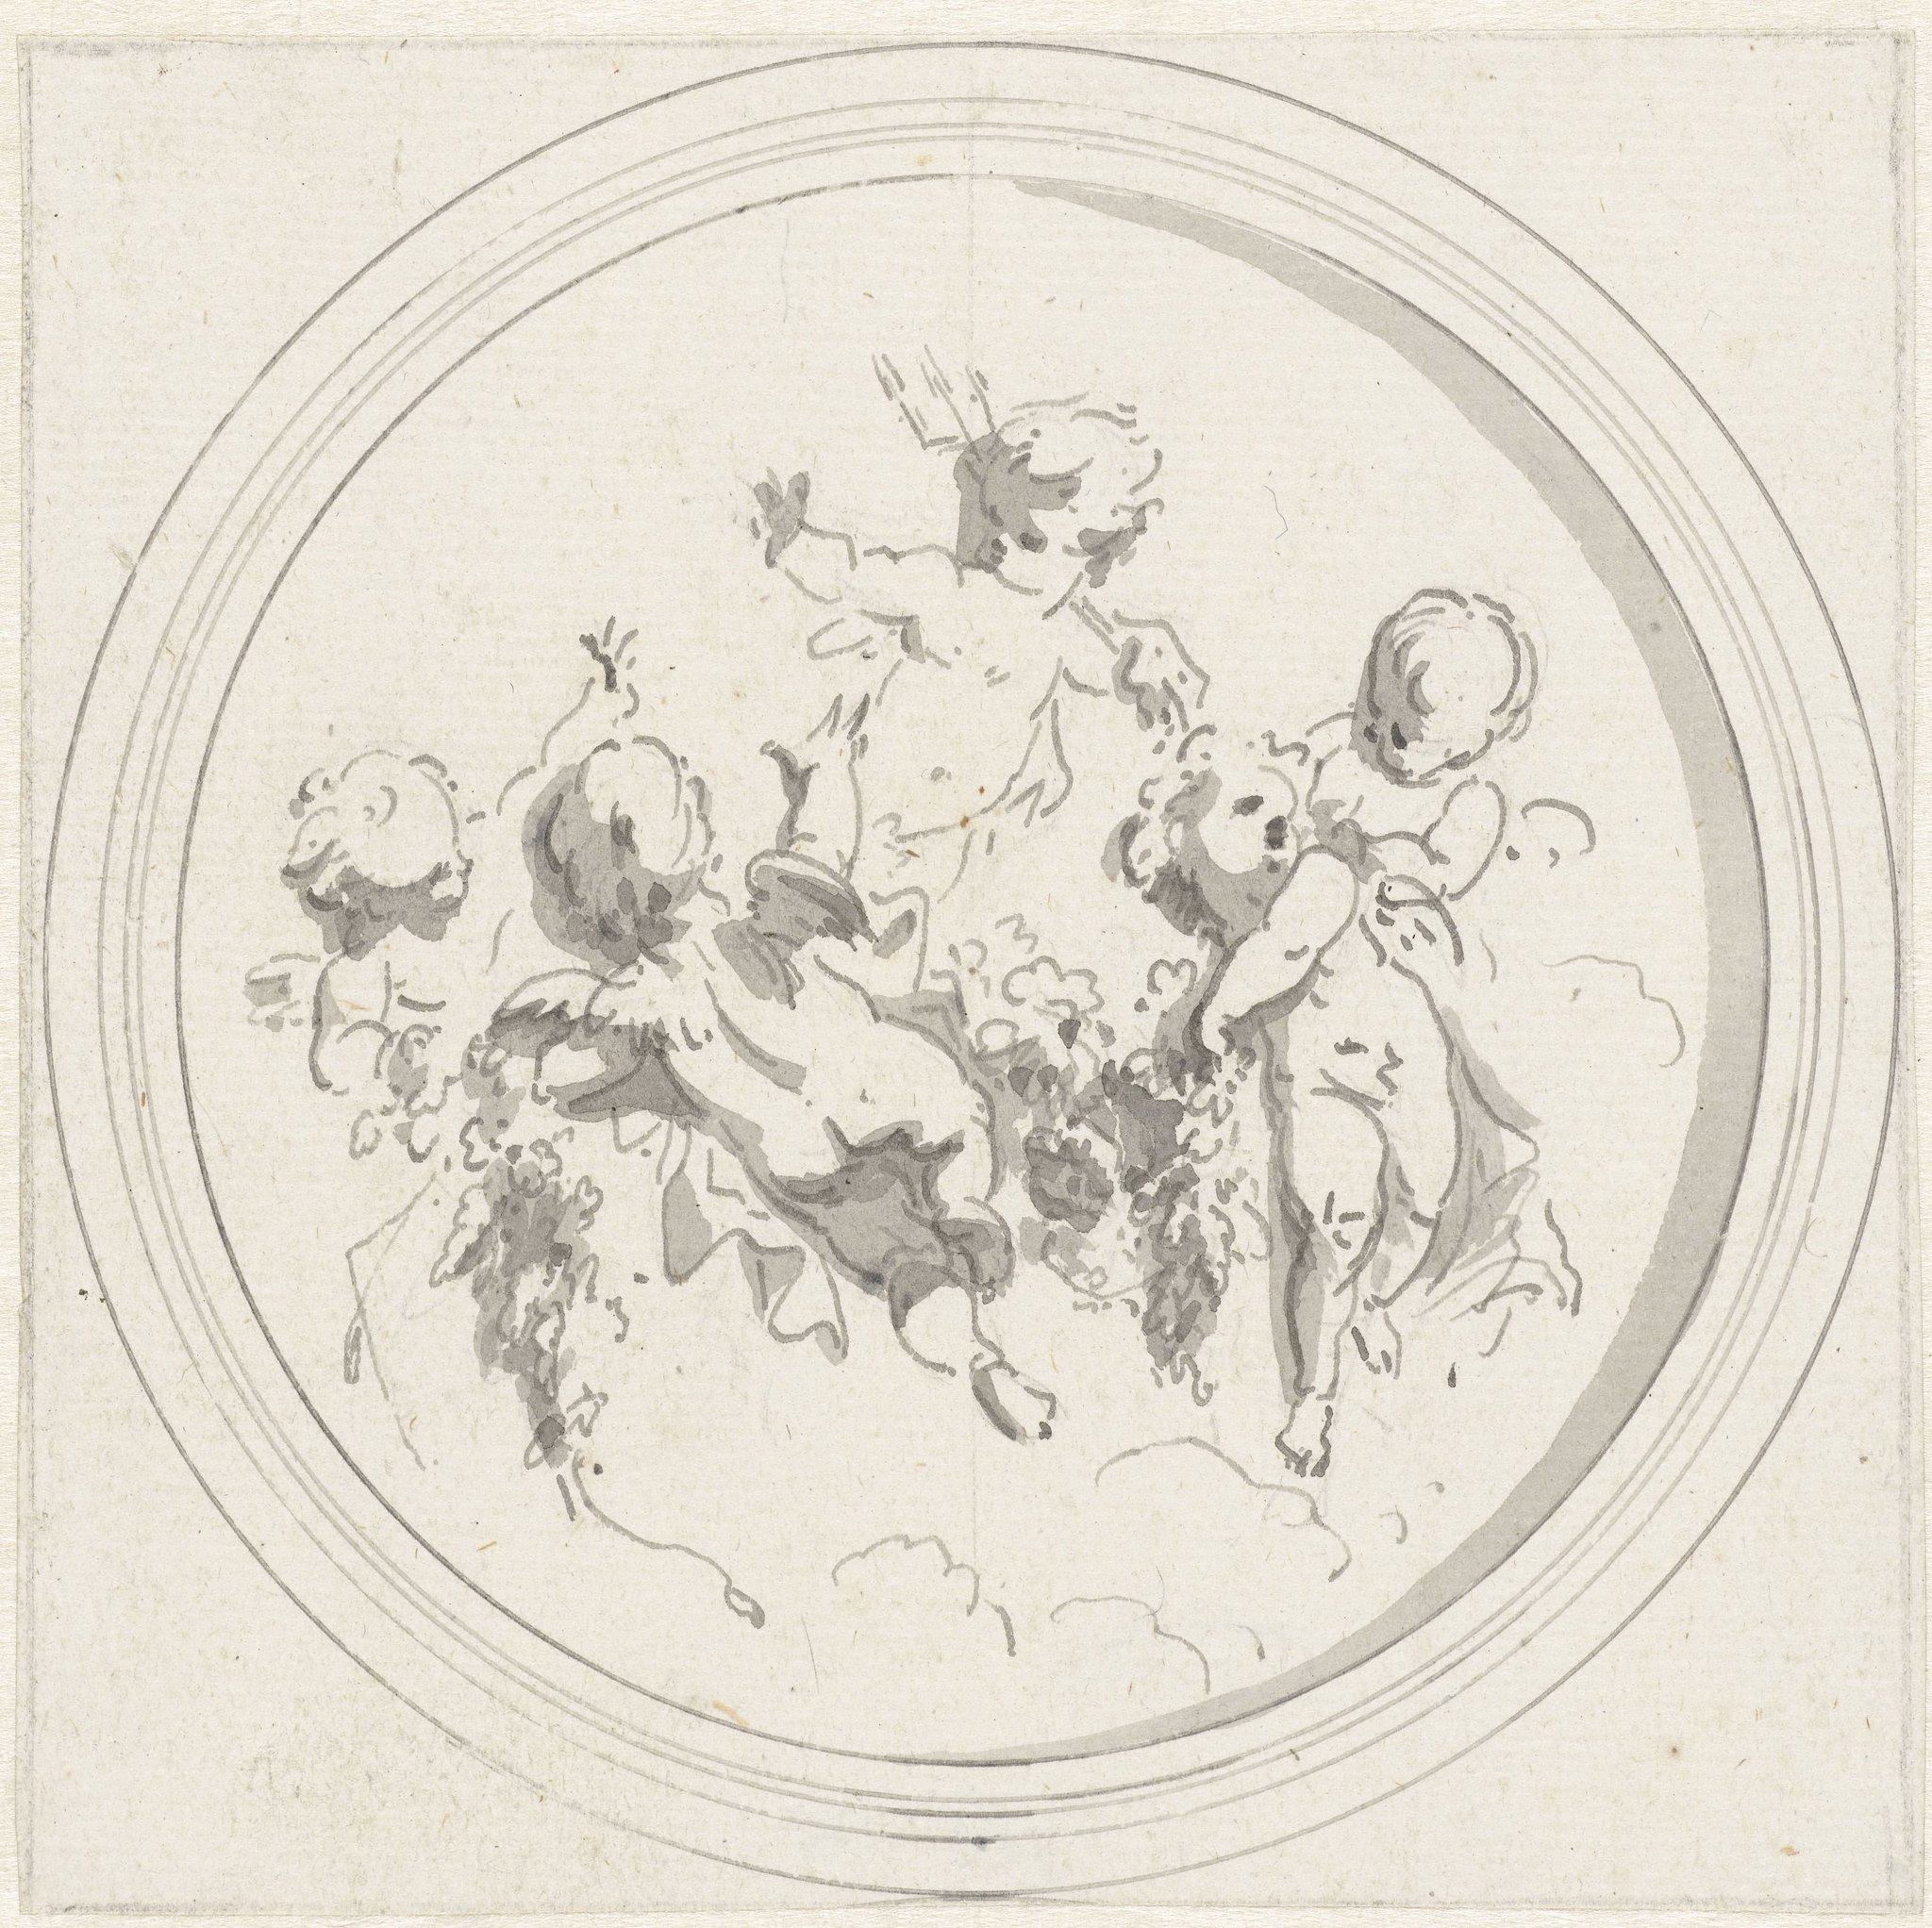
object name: drawing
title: Het element water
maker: Anonymous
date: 1705-1754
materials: chalk, paper, pencil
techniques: brush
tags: 'acqua', 'carro dell'acqua' (ripa), cupids: 'amores', 'amoretti', 'putti'